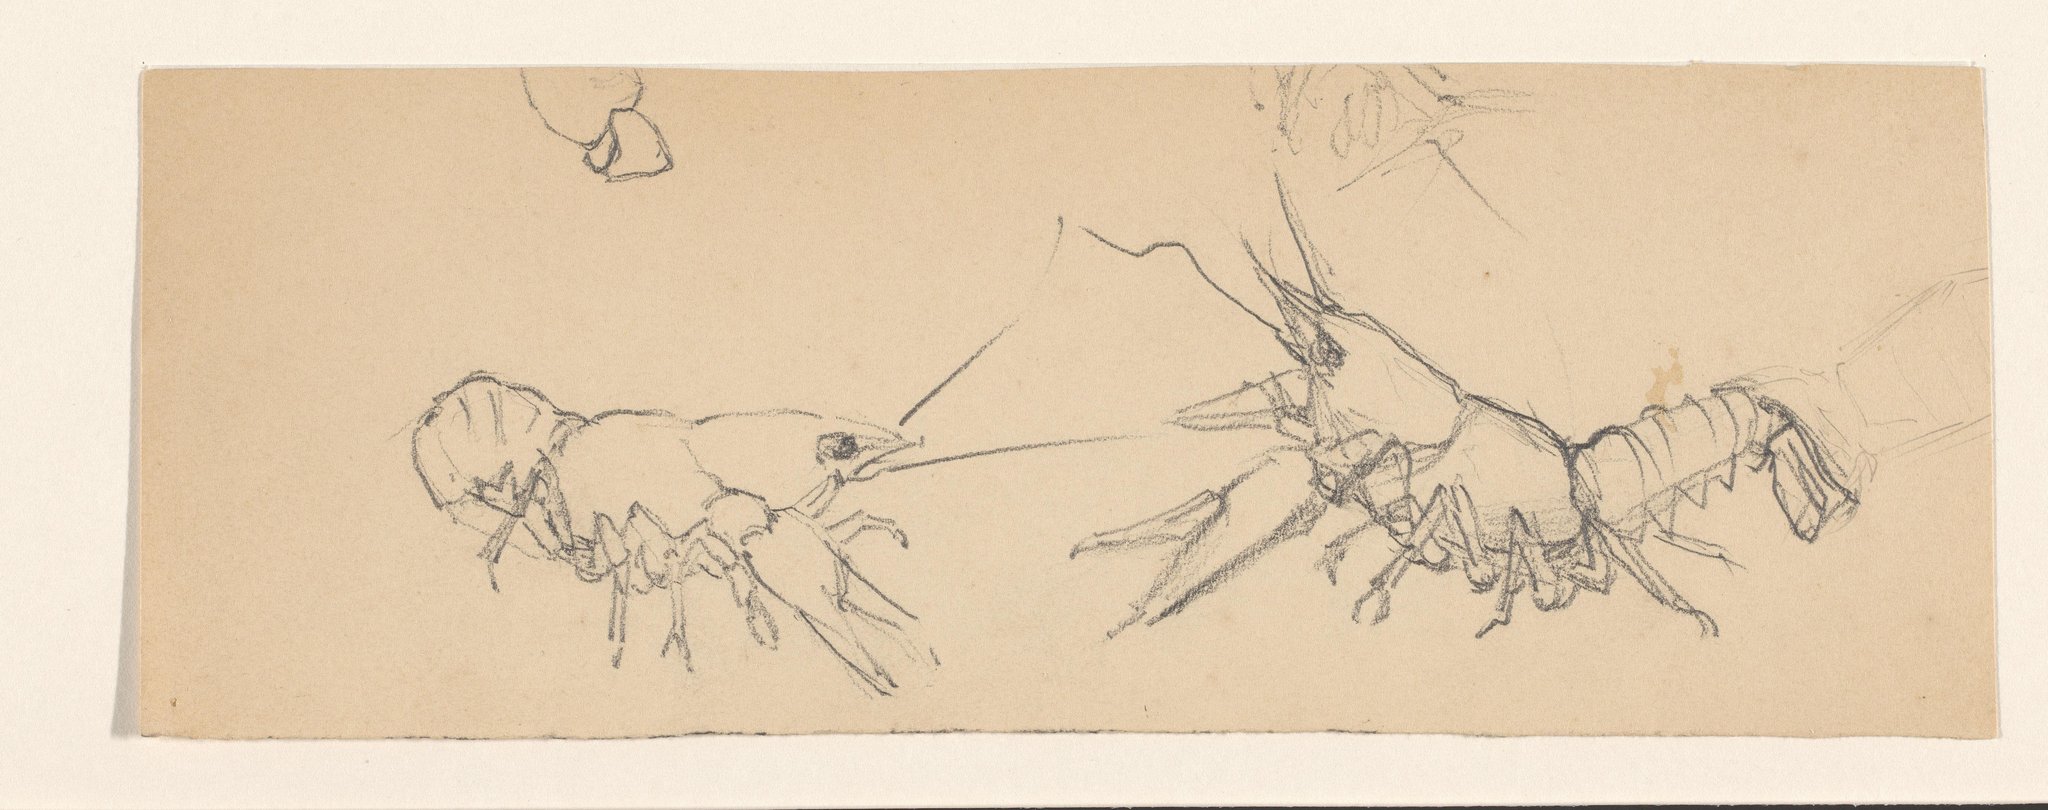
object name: drawing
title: Twee kreeften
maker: julie de graag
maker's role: draughtsman, print maker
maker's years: 1877-1924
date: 1887-1924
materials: paper, pencil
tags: crustaceans: lobster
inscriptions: annotation: ‘R P’, number: ‘204’